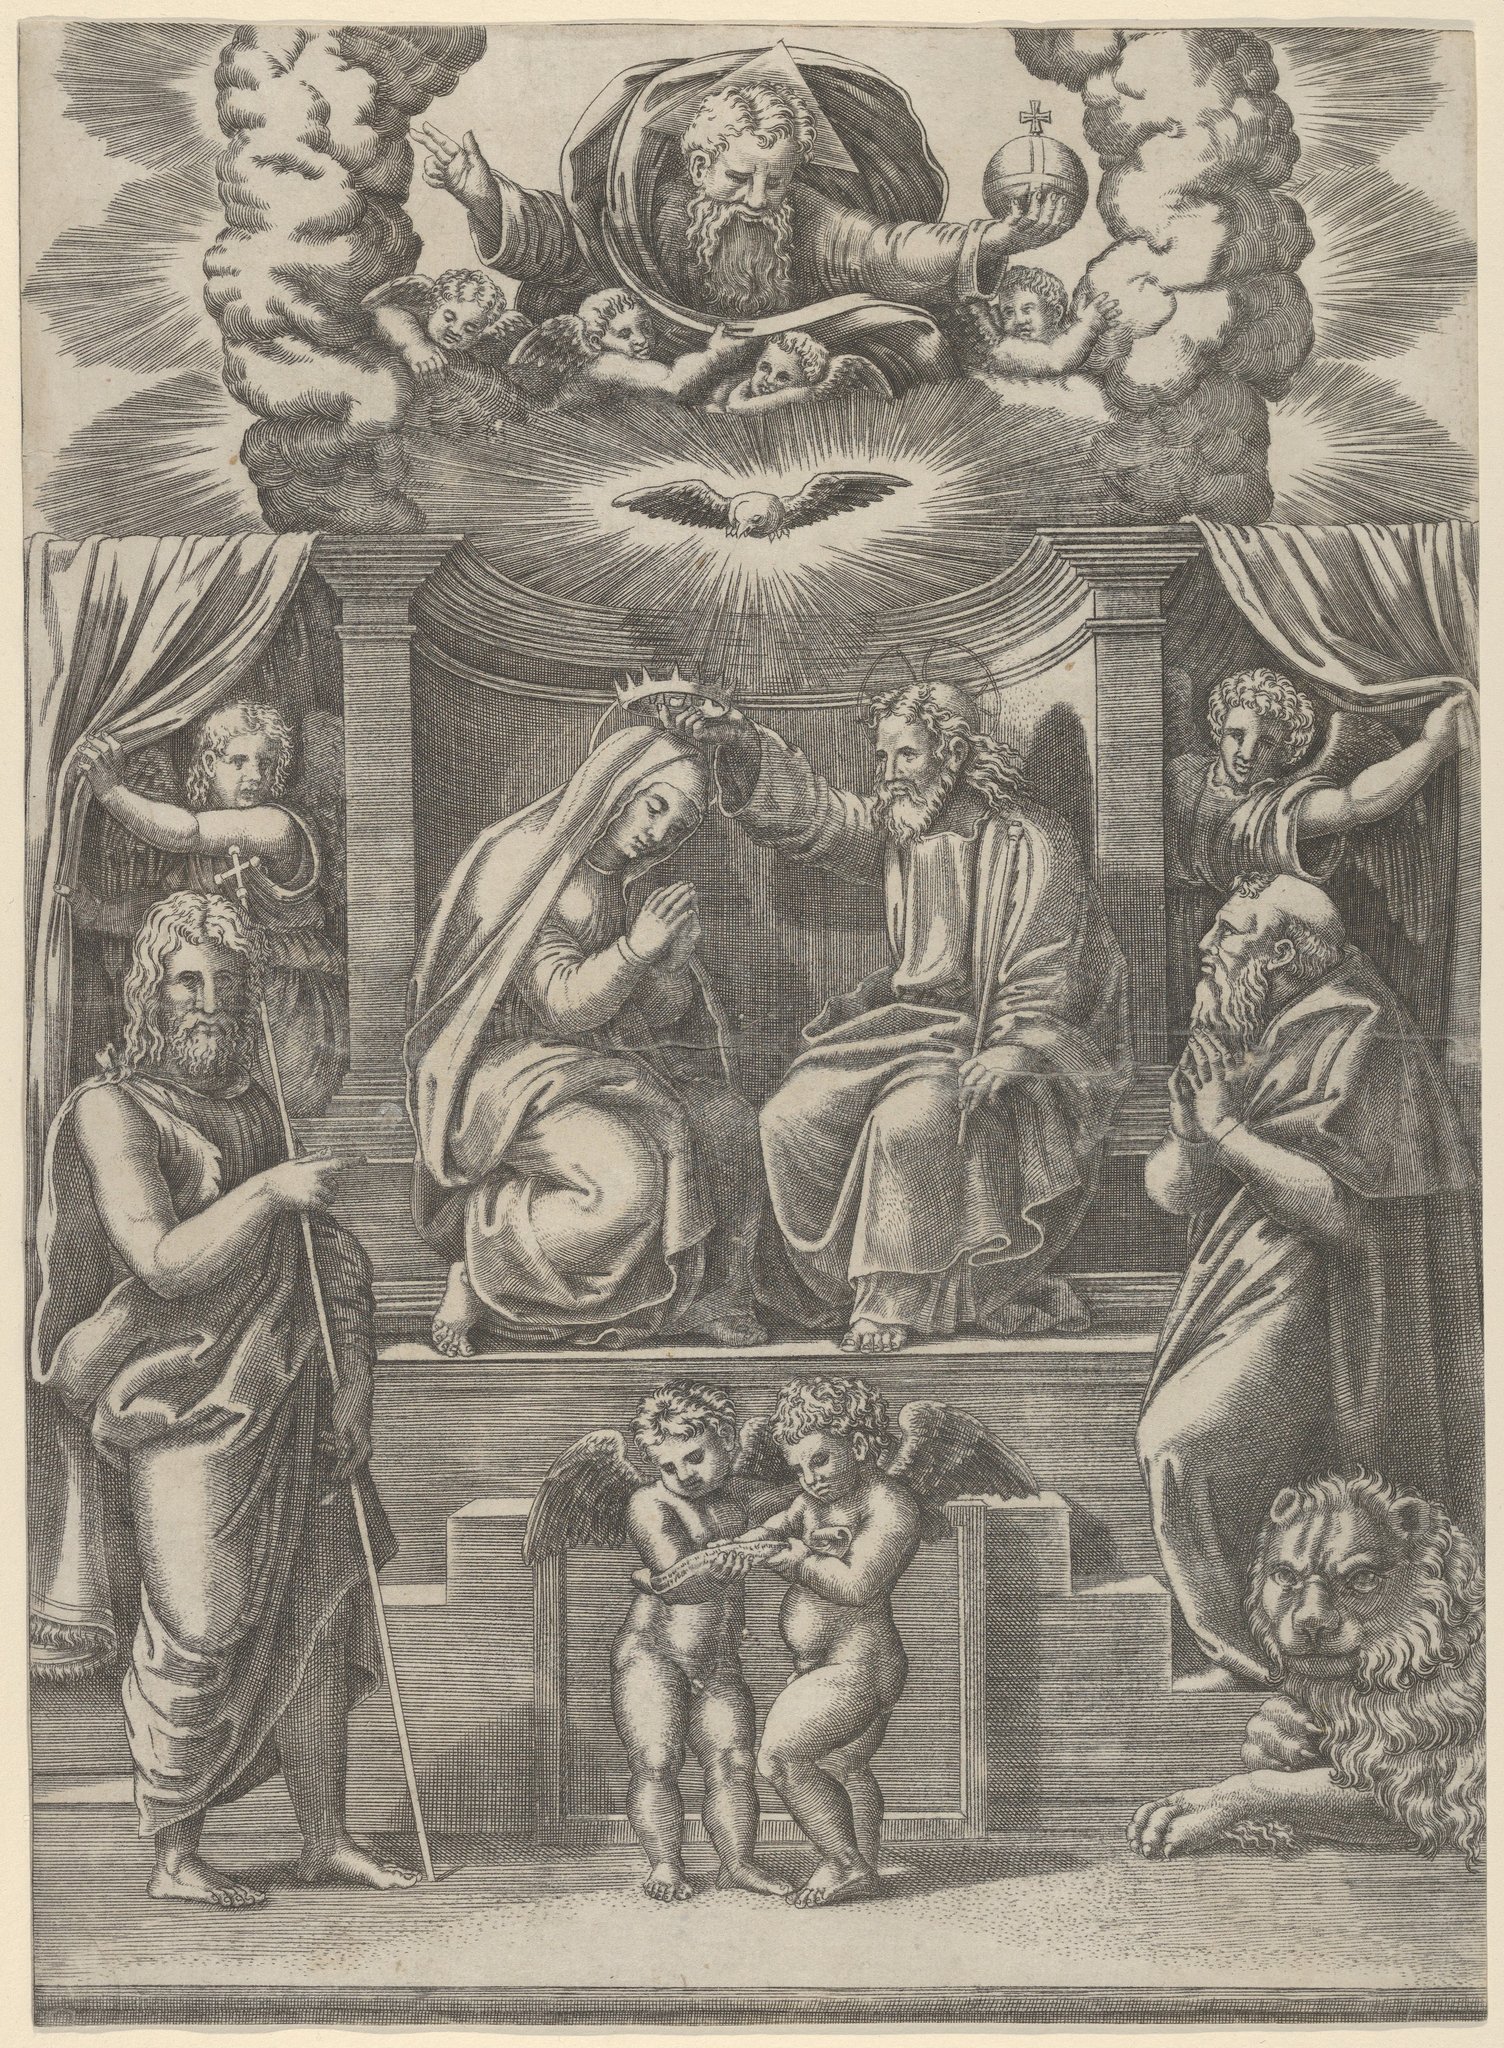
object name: print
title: The coronation of the Virgin, God the Father above, St Jerome lower right and St John the Baptist lower left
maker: master of the die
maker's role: artist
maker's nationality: italian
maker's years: 1525-1560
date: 1530-1560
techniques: engraving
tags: angels,saint jerome,saint john the baptist,virgin mary,god the father